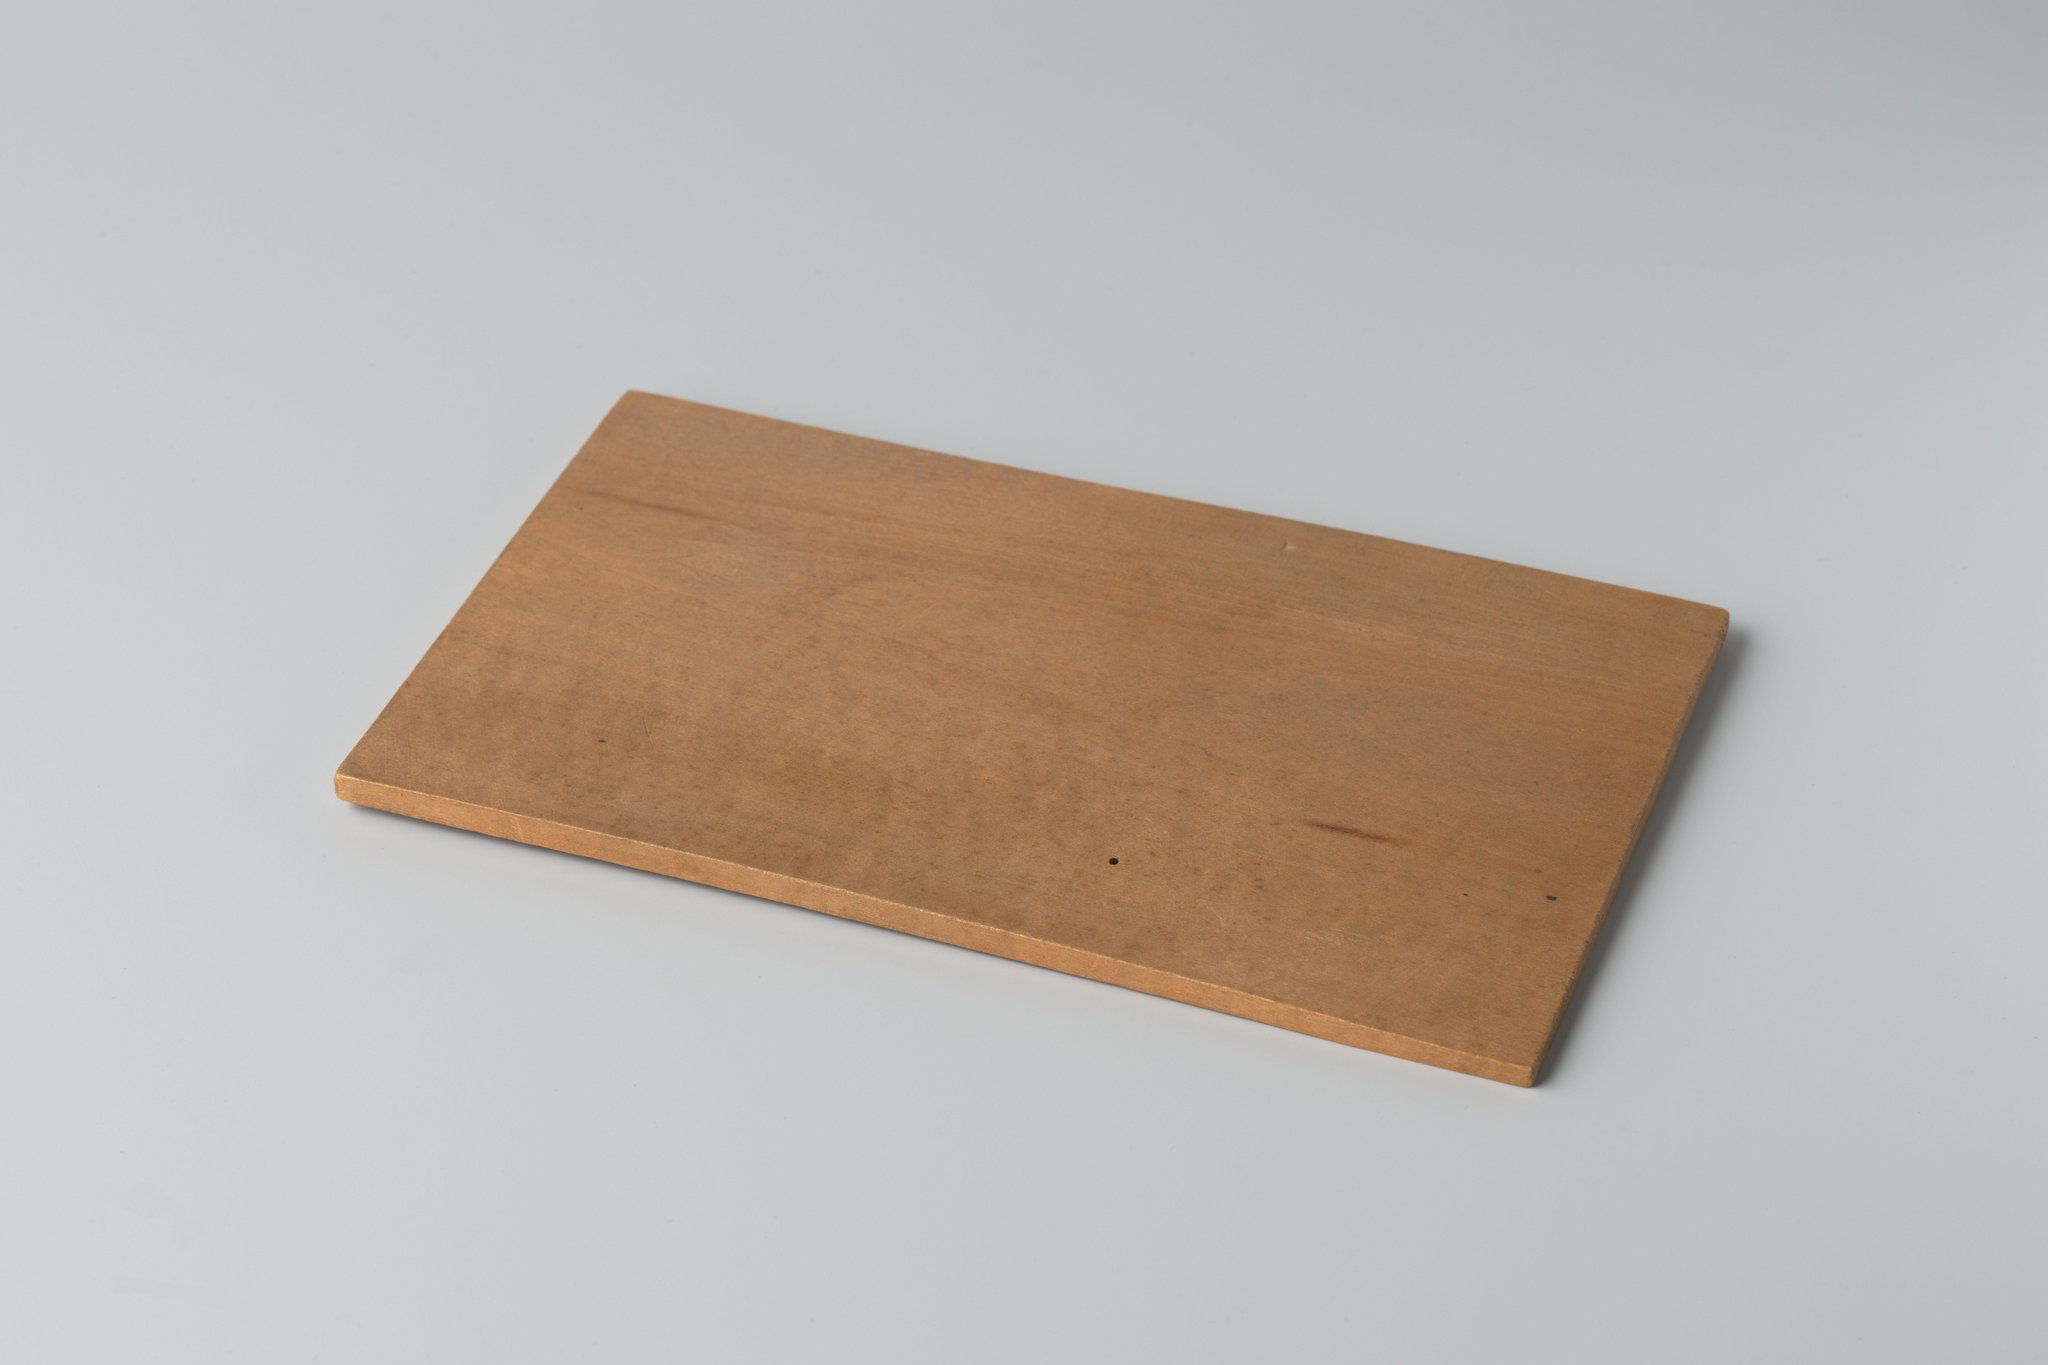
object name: miniature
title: Tafelblad van without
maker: Anonymous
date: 1676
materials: without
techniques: without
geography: amsterdam